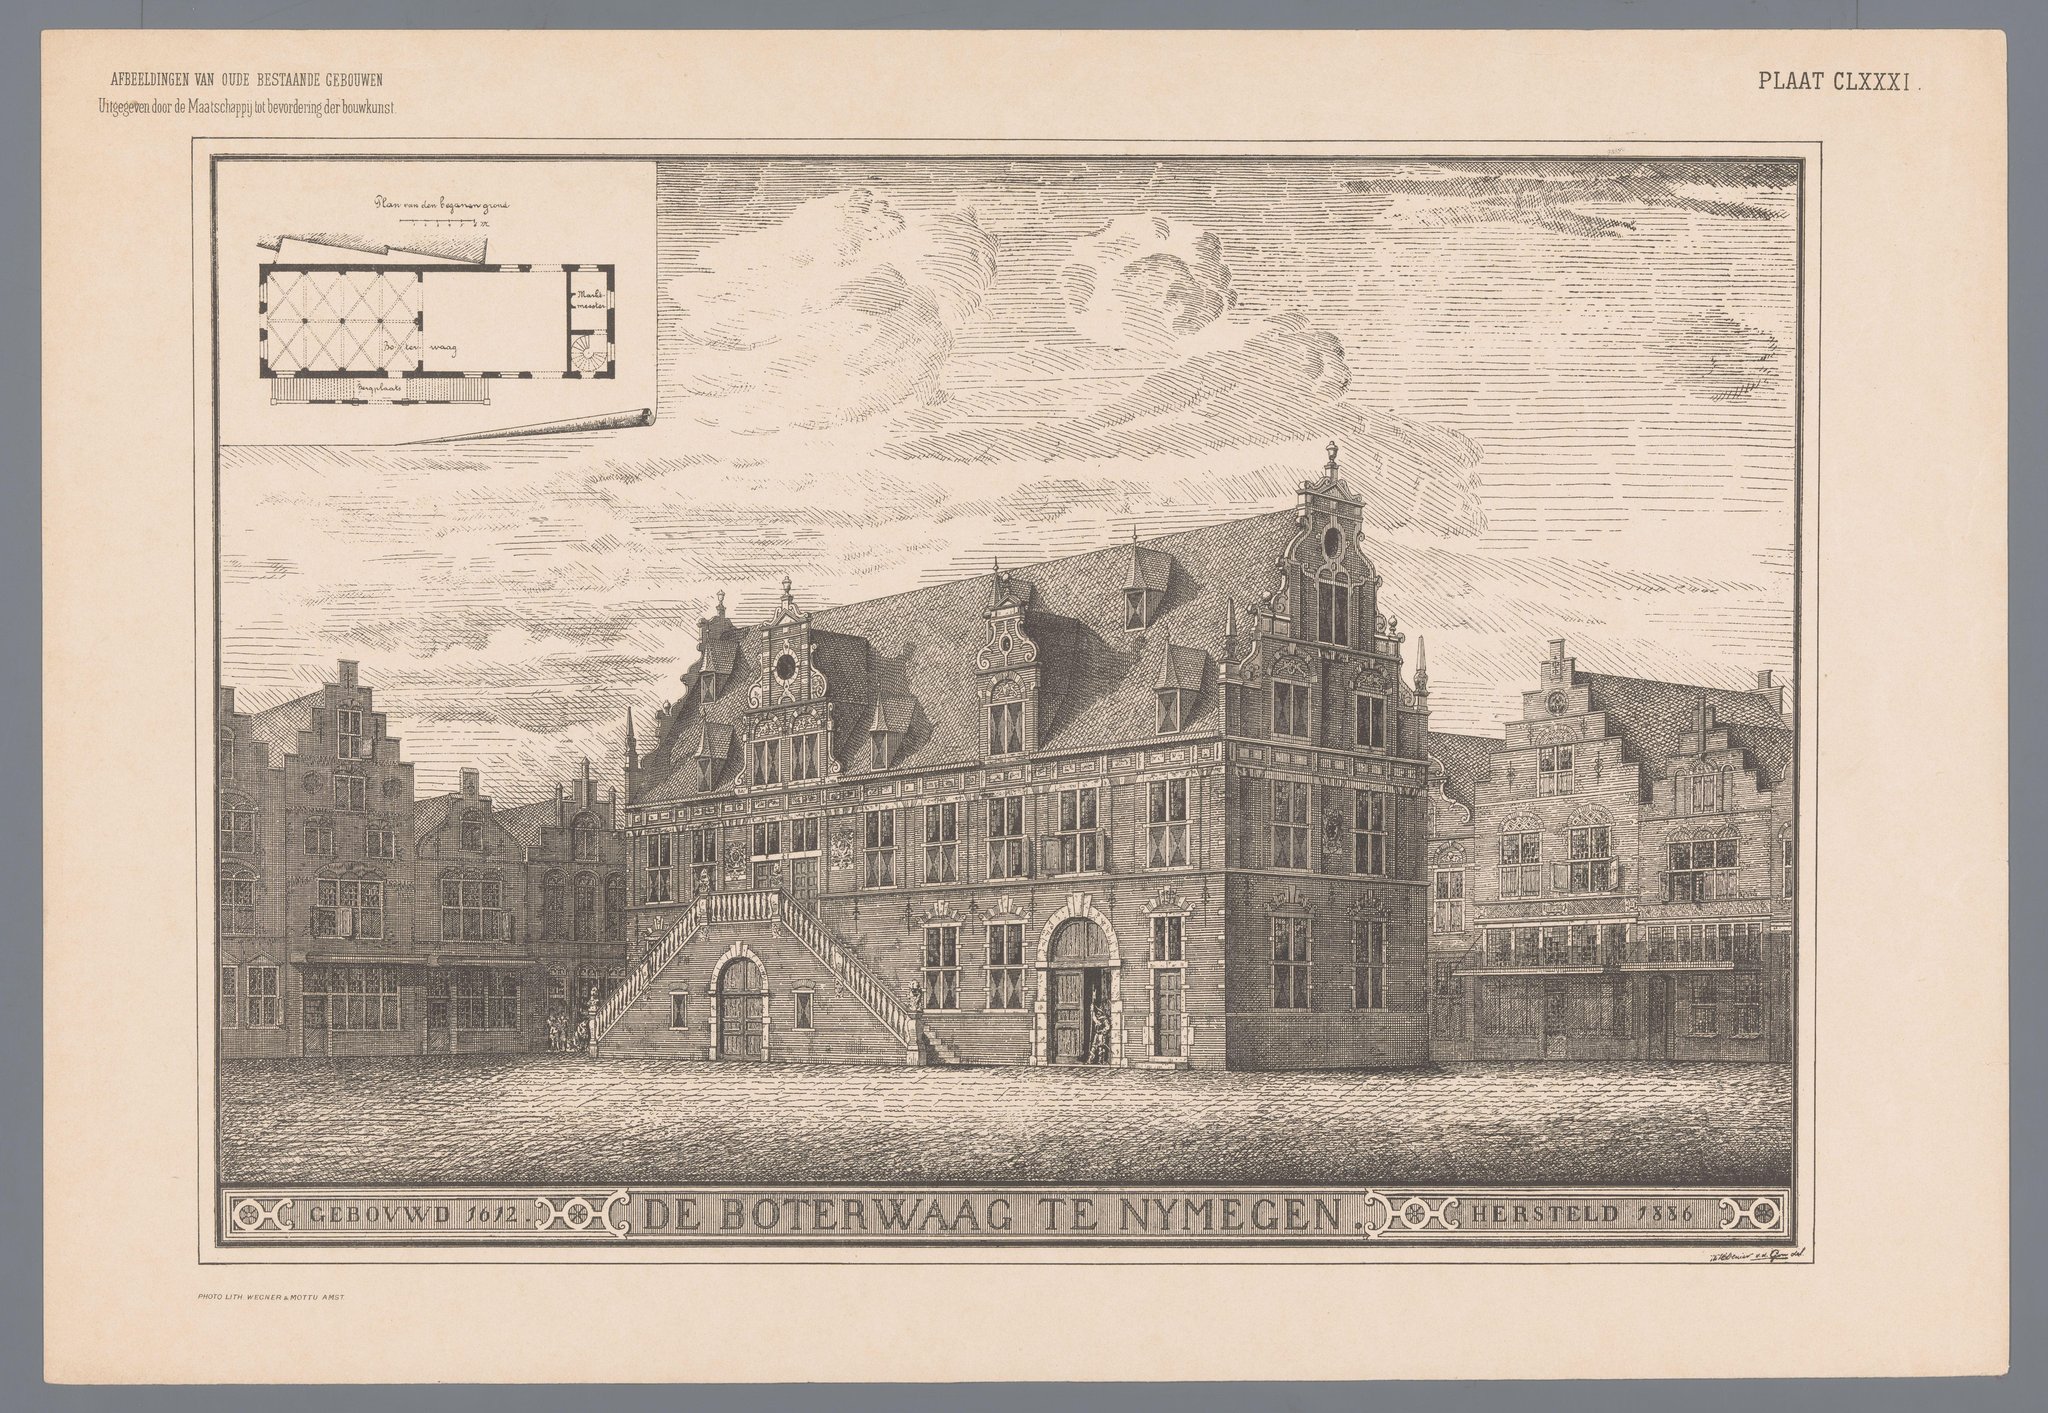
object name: reproduction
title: Reproductie van een prent of tekening met de Boterwaag te Nijmegen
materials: paper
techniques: photolithography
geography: amsterdam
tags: weigh-house